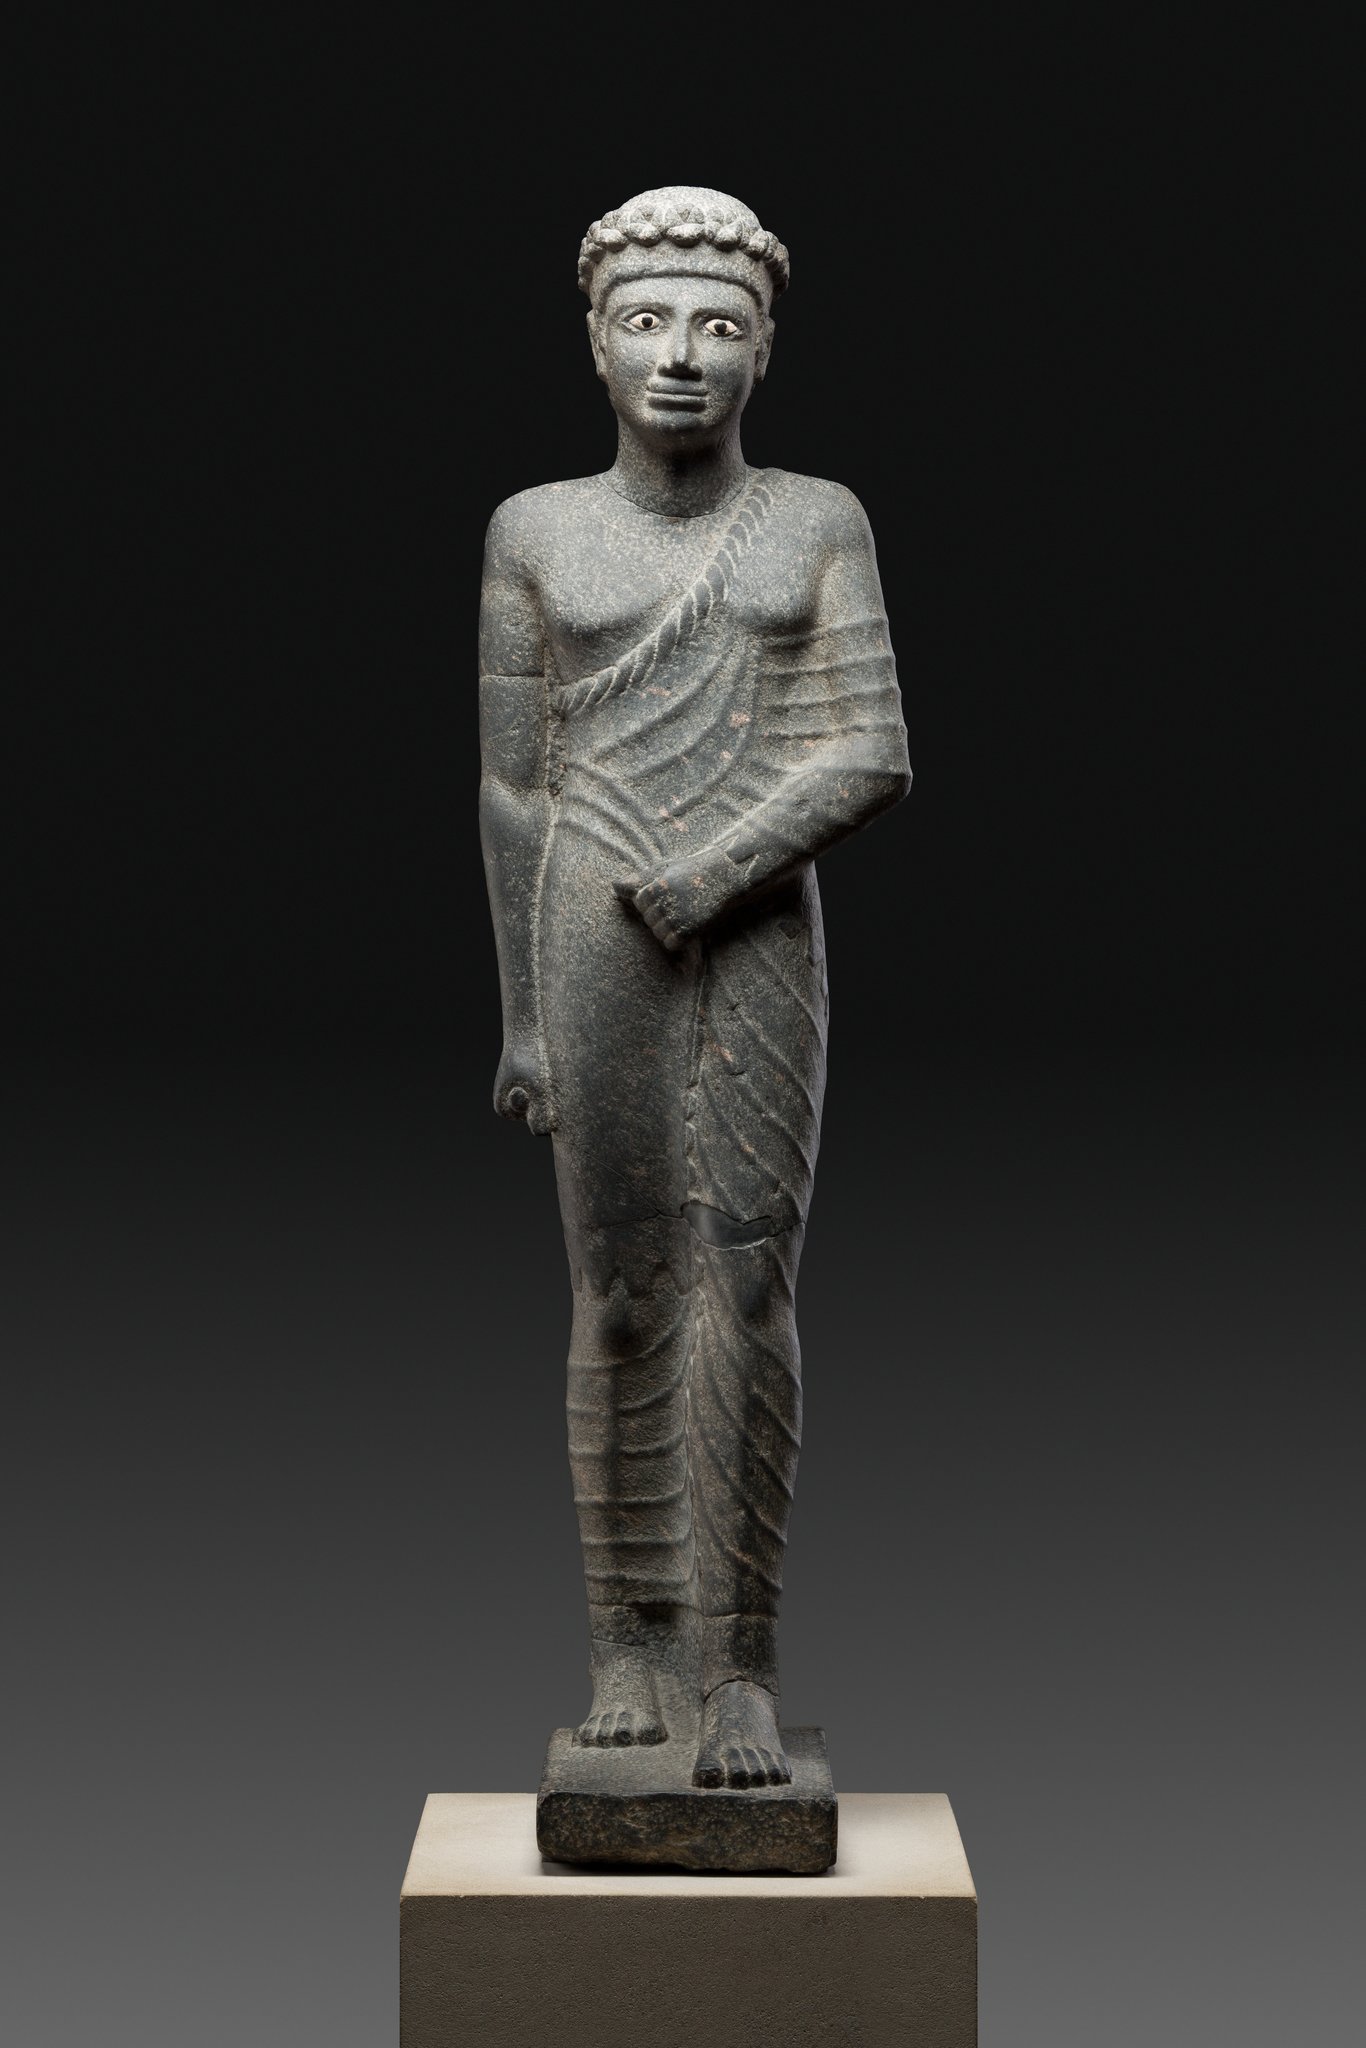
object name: statue, draped male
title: Official with Pleated Costume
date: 150-1 BCE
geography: egypt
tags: men,portraits